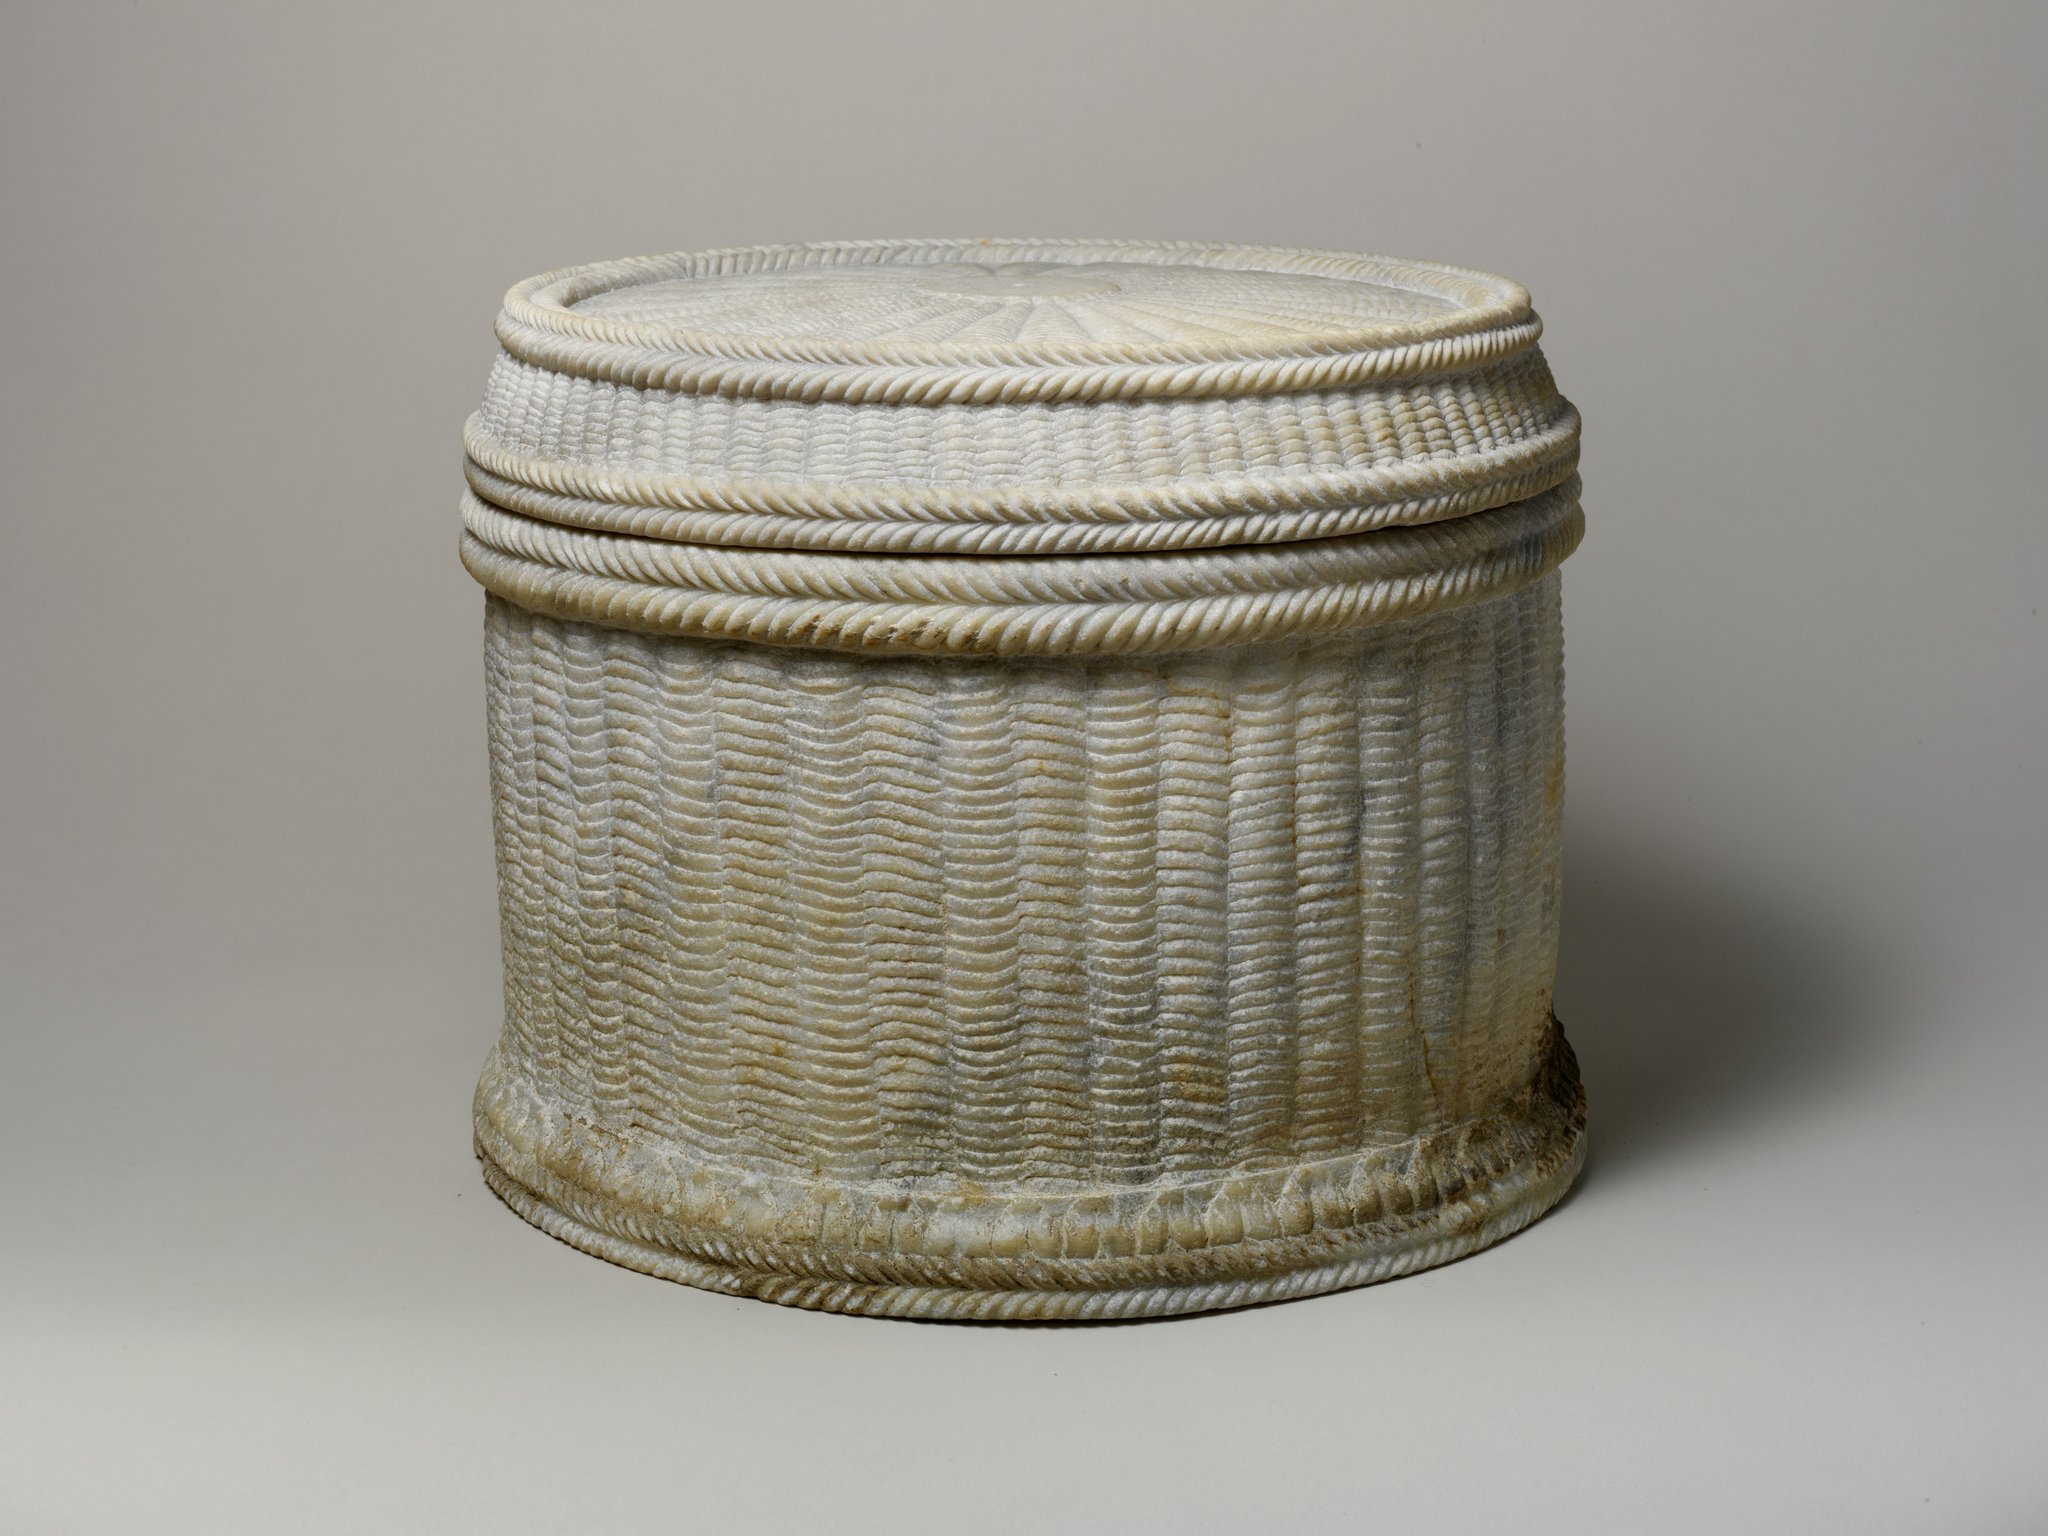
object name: urn in the form of a cylindrical basket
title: Marble cinerary urn with lid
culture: roman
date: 10 BCE-10 CE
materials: marble